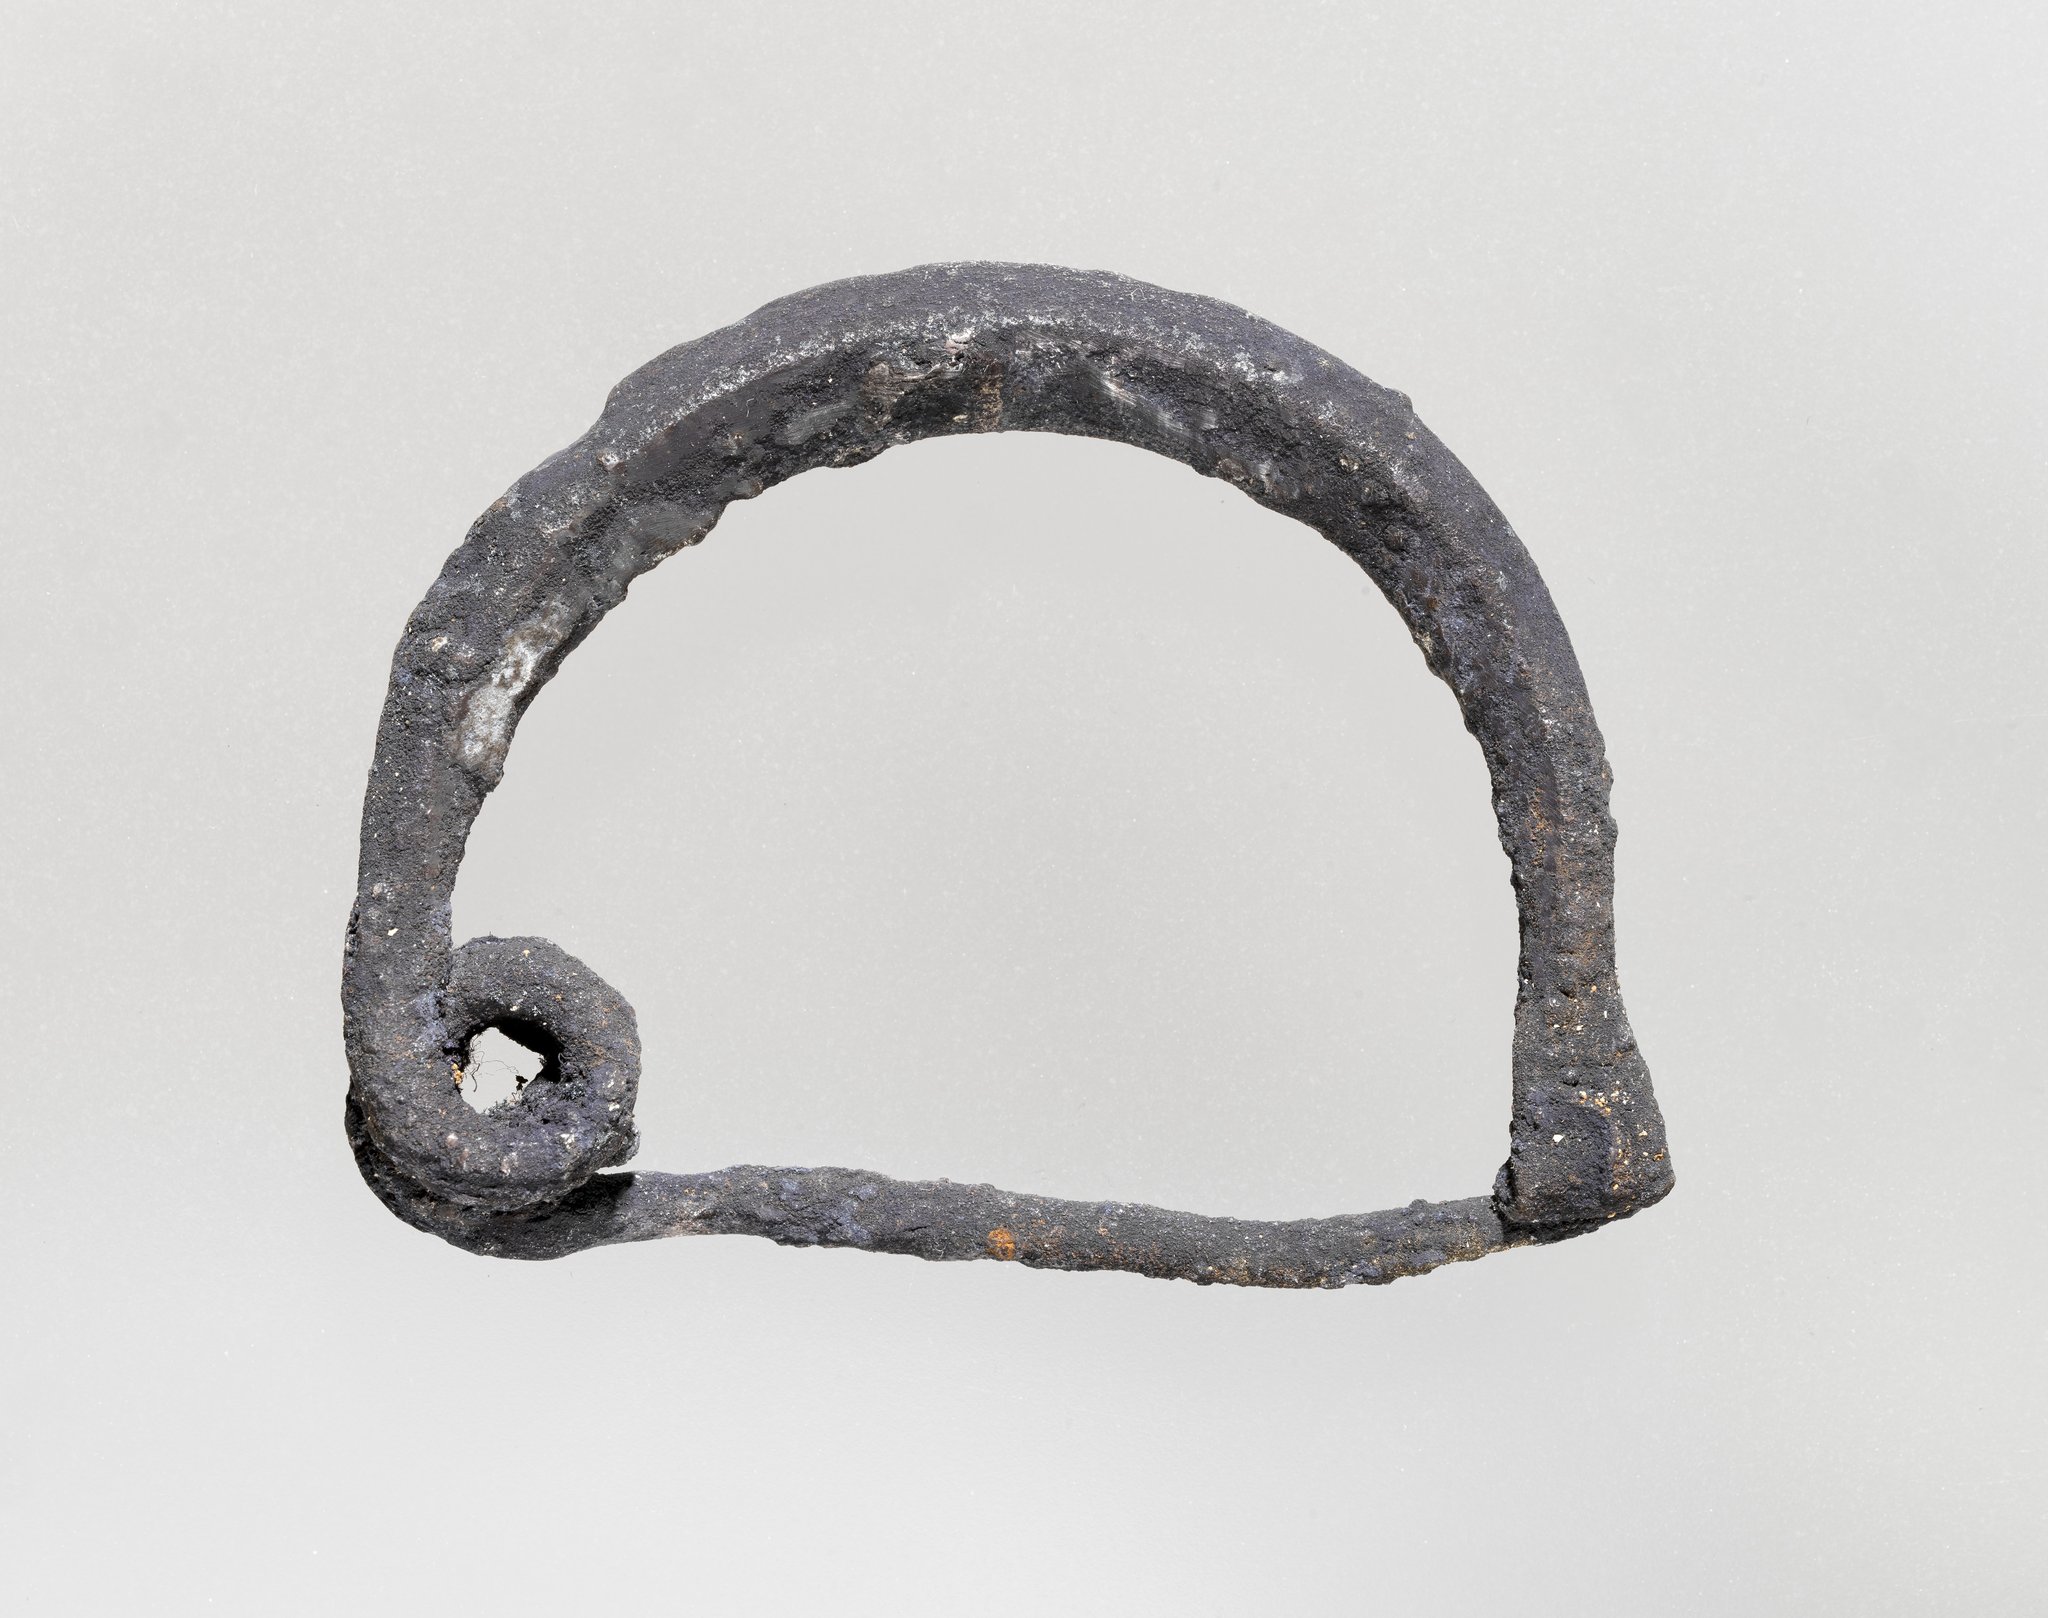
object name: fibula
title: Silver fibula (safety pin)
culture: cypriot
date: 900-701 BCE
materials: silver